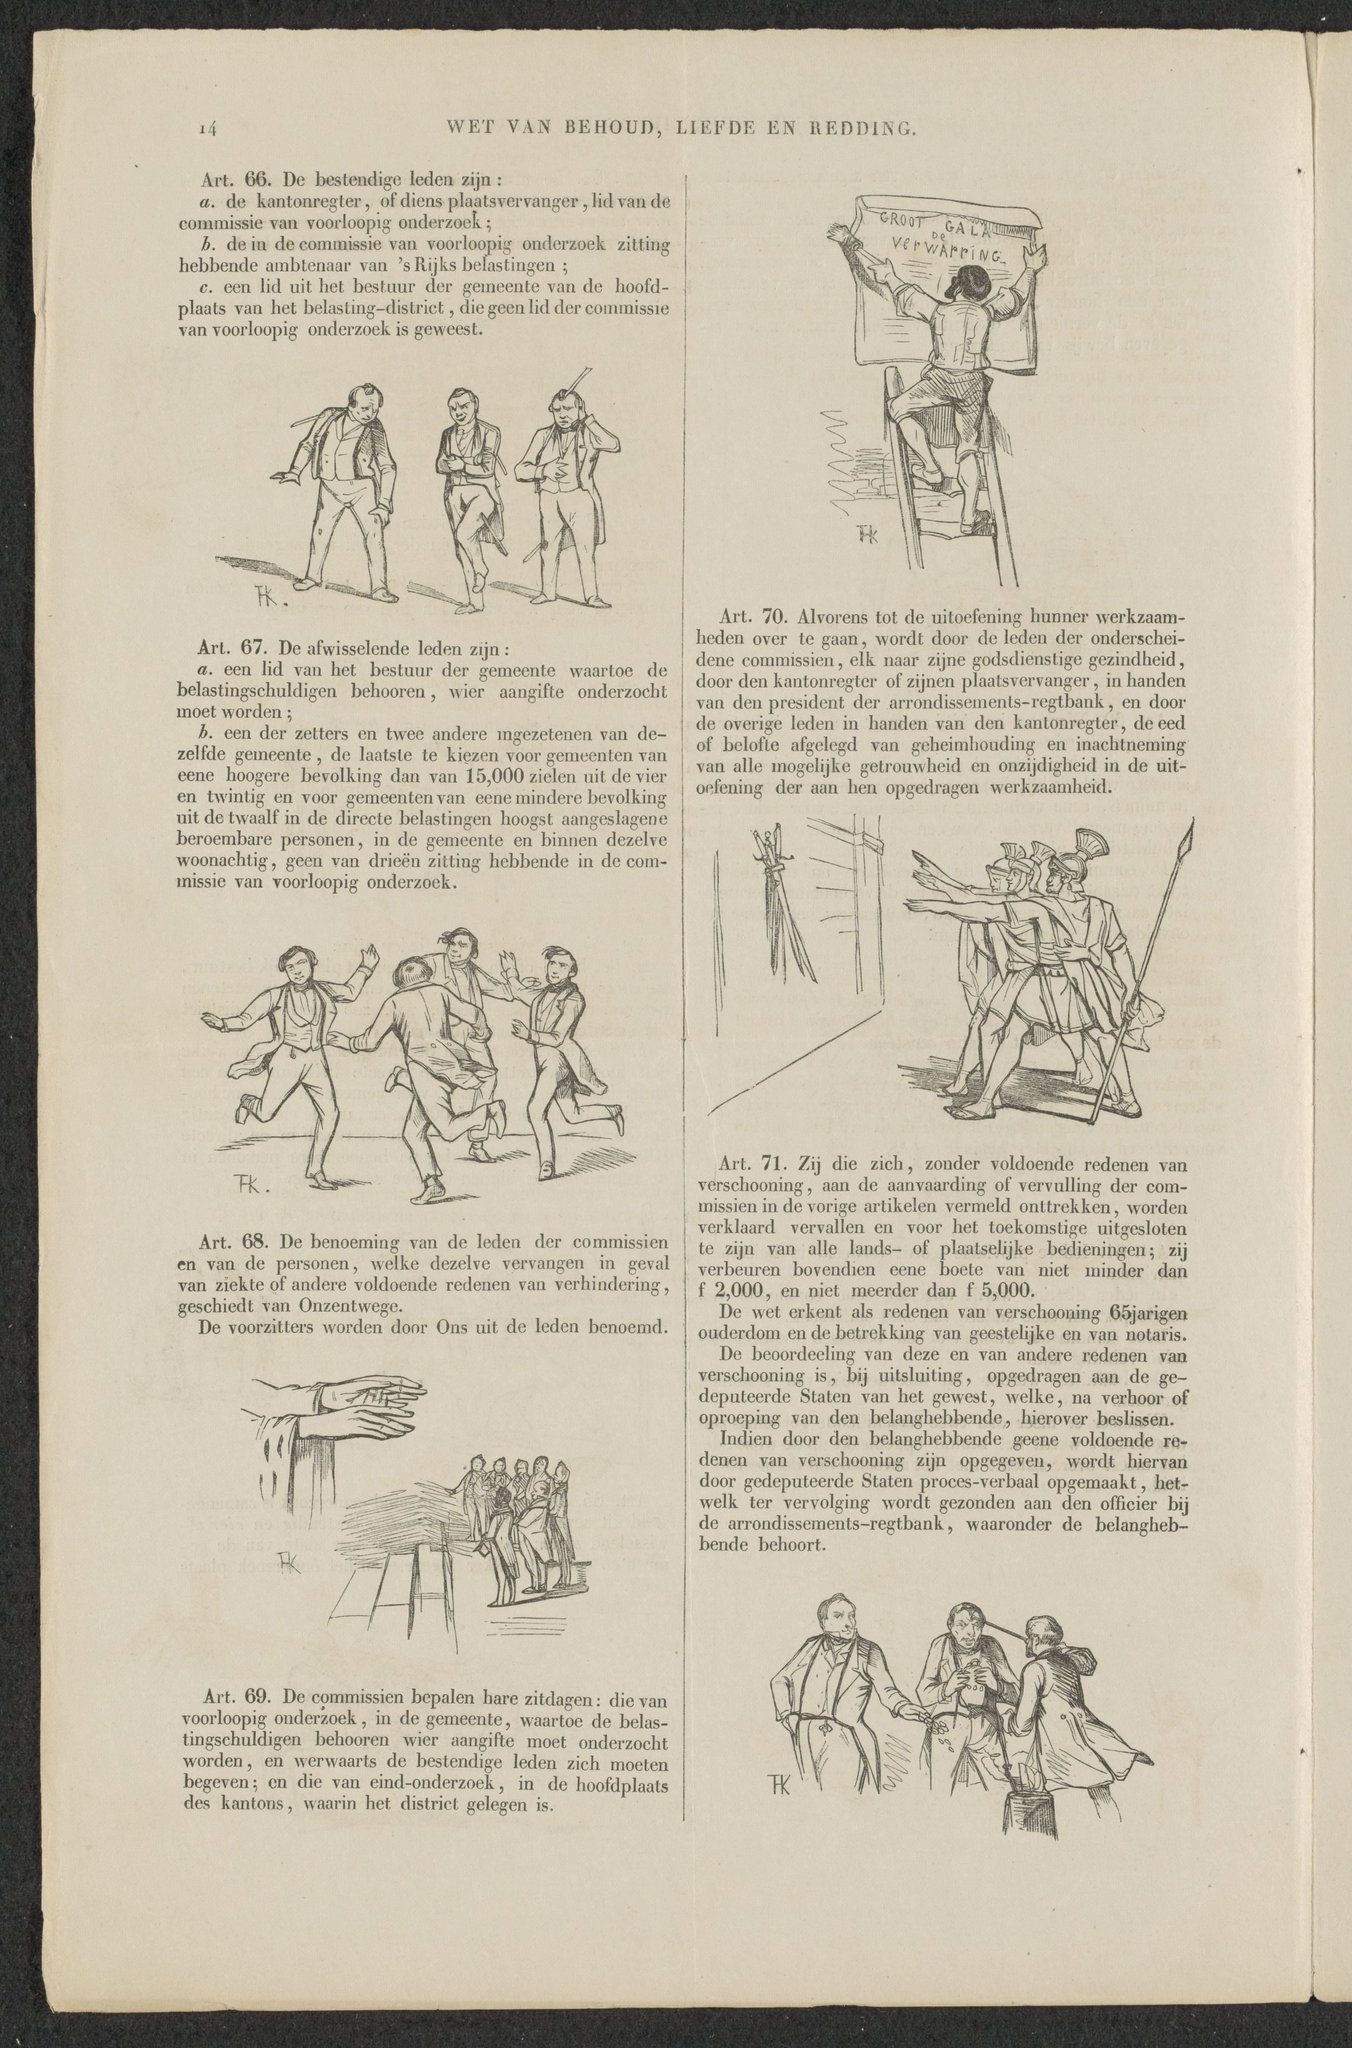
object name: print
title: Satire op de aansporing tot deelneming in de (zogenaamde) vrijwillige 3% geldlening van 1844 (blad 14)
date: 1844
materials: paper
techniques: letterpress printing, engraving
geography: the hague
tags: amsterdam, floris adriaan van hall, organization of trade and finance, taxes and financial administration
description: Bladzijde 14 met artikels 66-71 van de 'Wet van Behoud, Liefde en Redding'. Een satire in zestien bladzijden op de aansporing tot deelneming in de (zogenaamde) vrijwillige 3% geldlening uitgeschreven in maart 1844 door minister F.A. van Hall. Binnenzijde van een dubbelgevouwen blad bedrukt op alle zijden.